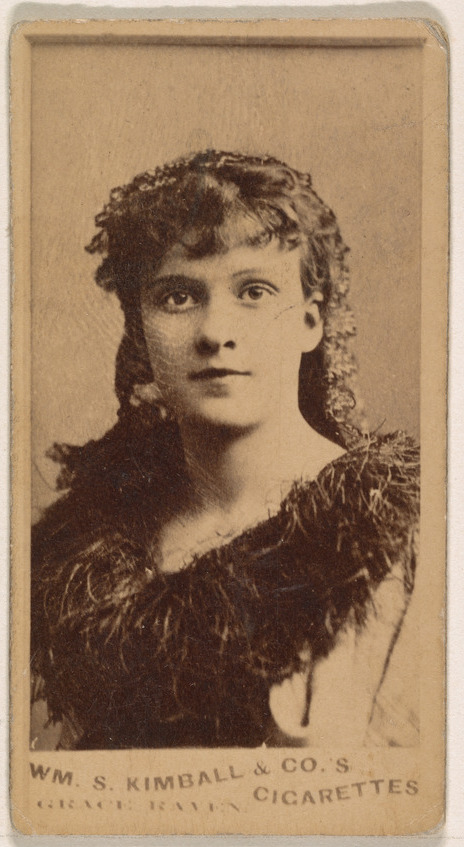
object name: photograph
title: Grace Raven, from the Actresses series (N203) issued by Wm. S. Kimball & Co.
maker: william s. kimball & company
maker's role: publisher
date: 1889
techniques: color lithograph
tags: portraits,women,actresses